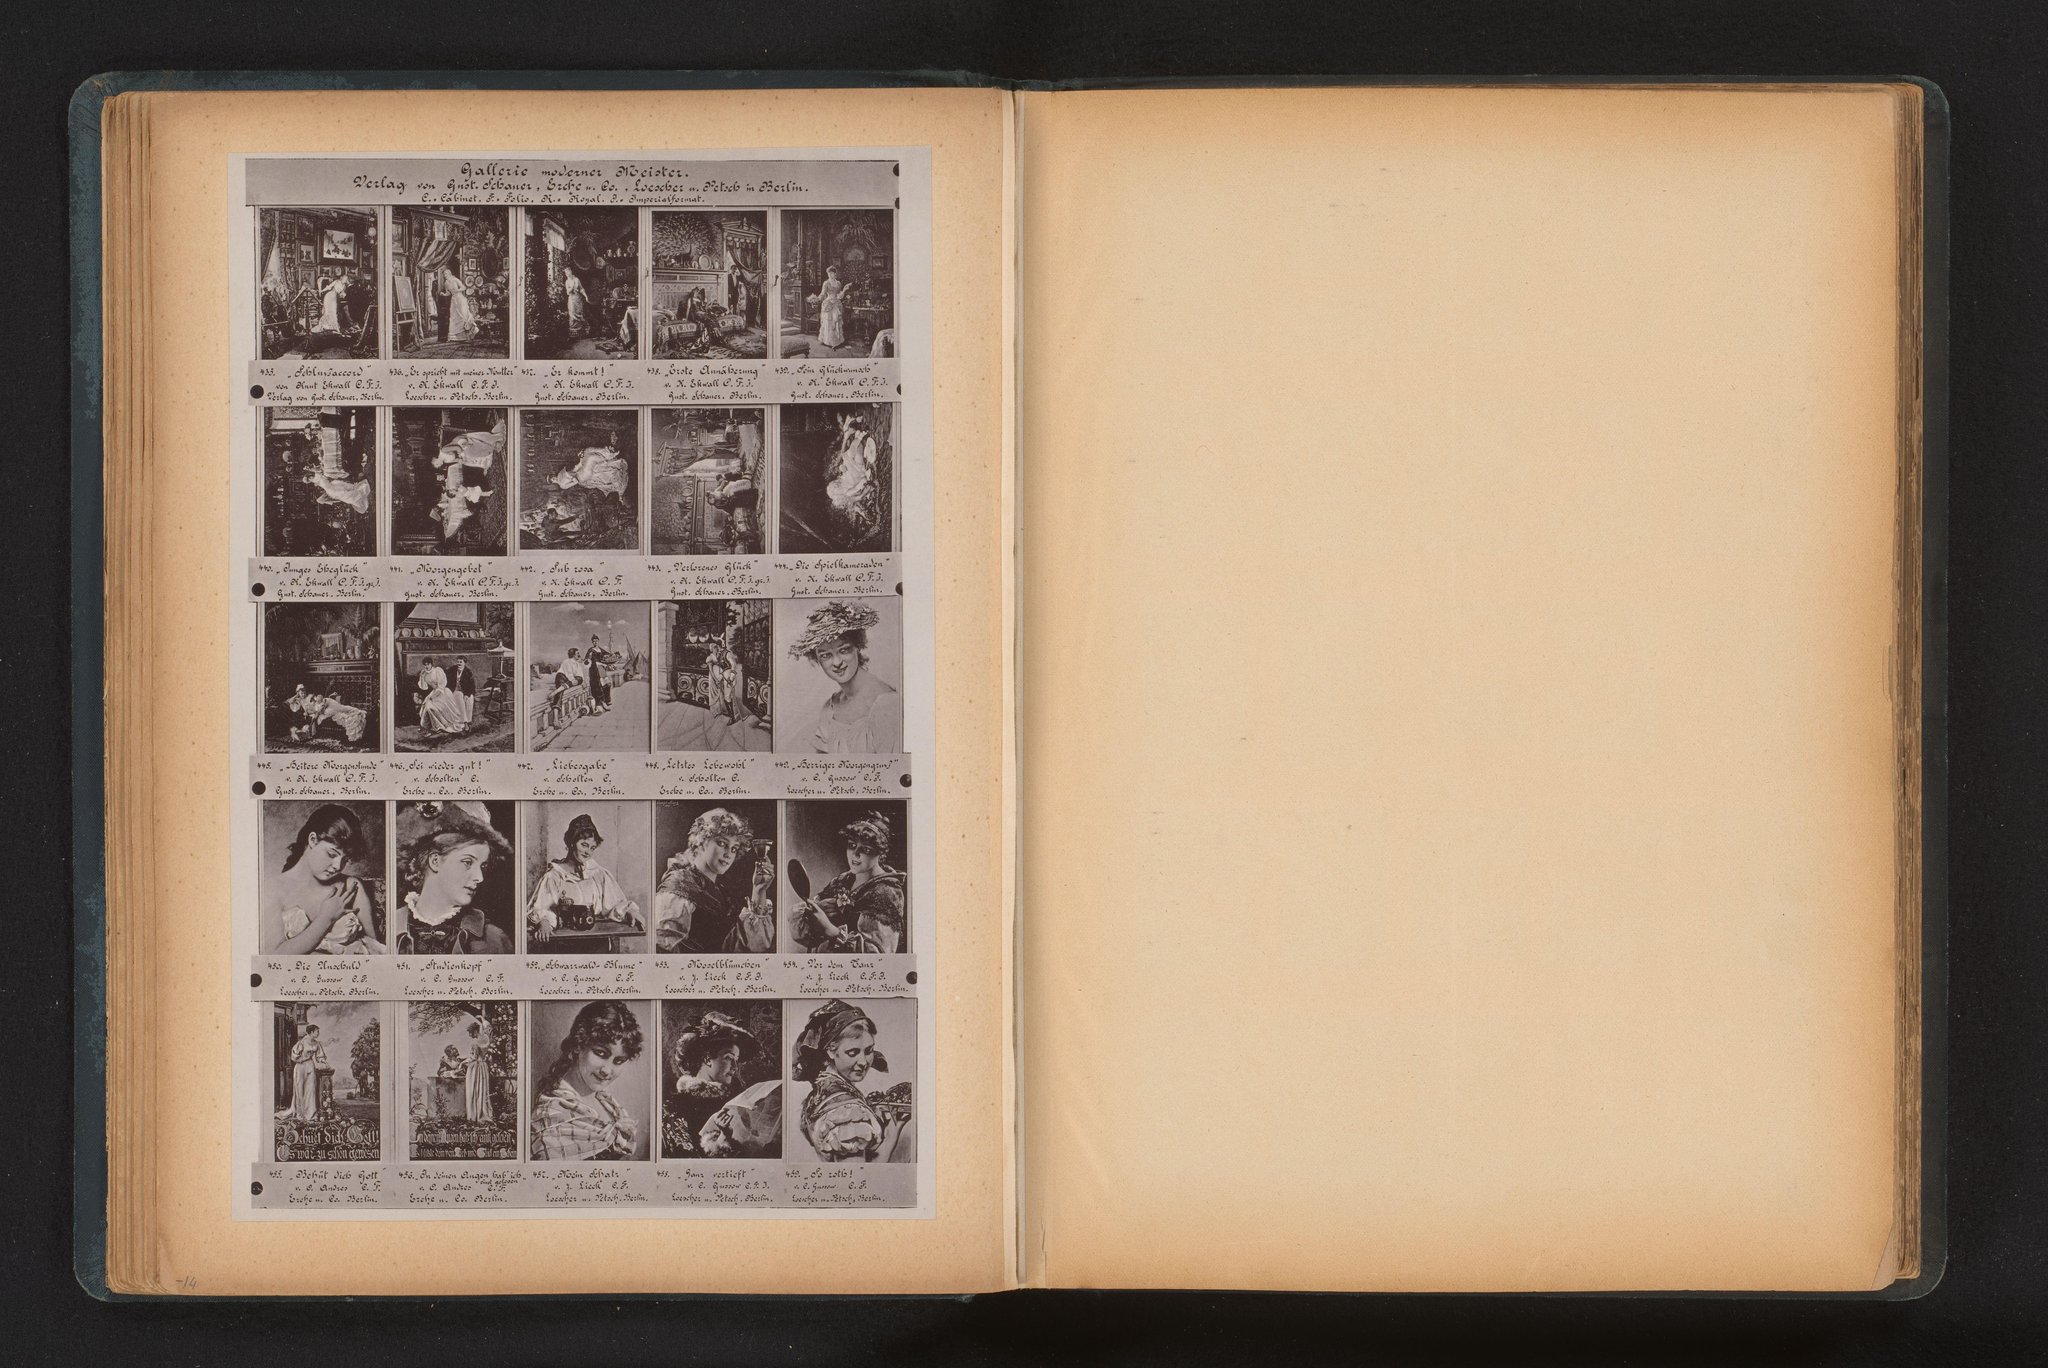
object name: reproduction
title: Gallerie moderner Meister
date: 1880-1885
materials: paper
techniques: photograph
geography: berlin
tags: anonymous historical person portrayed - bb - woman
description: Prent op veertiende ongenummerde pagina.